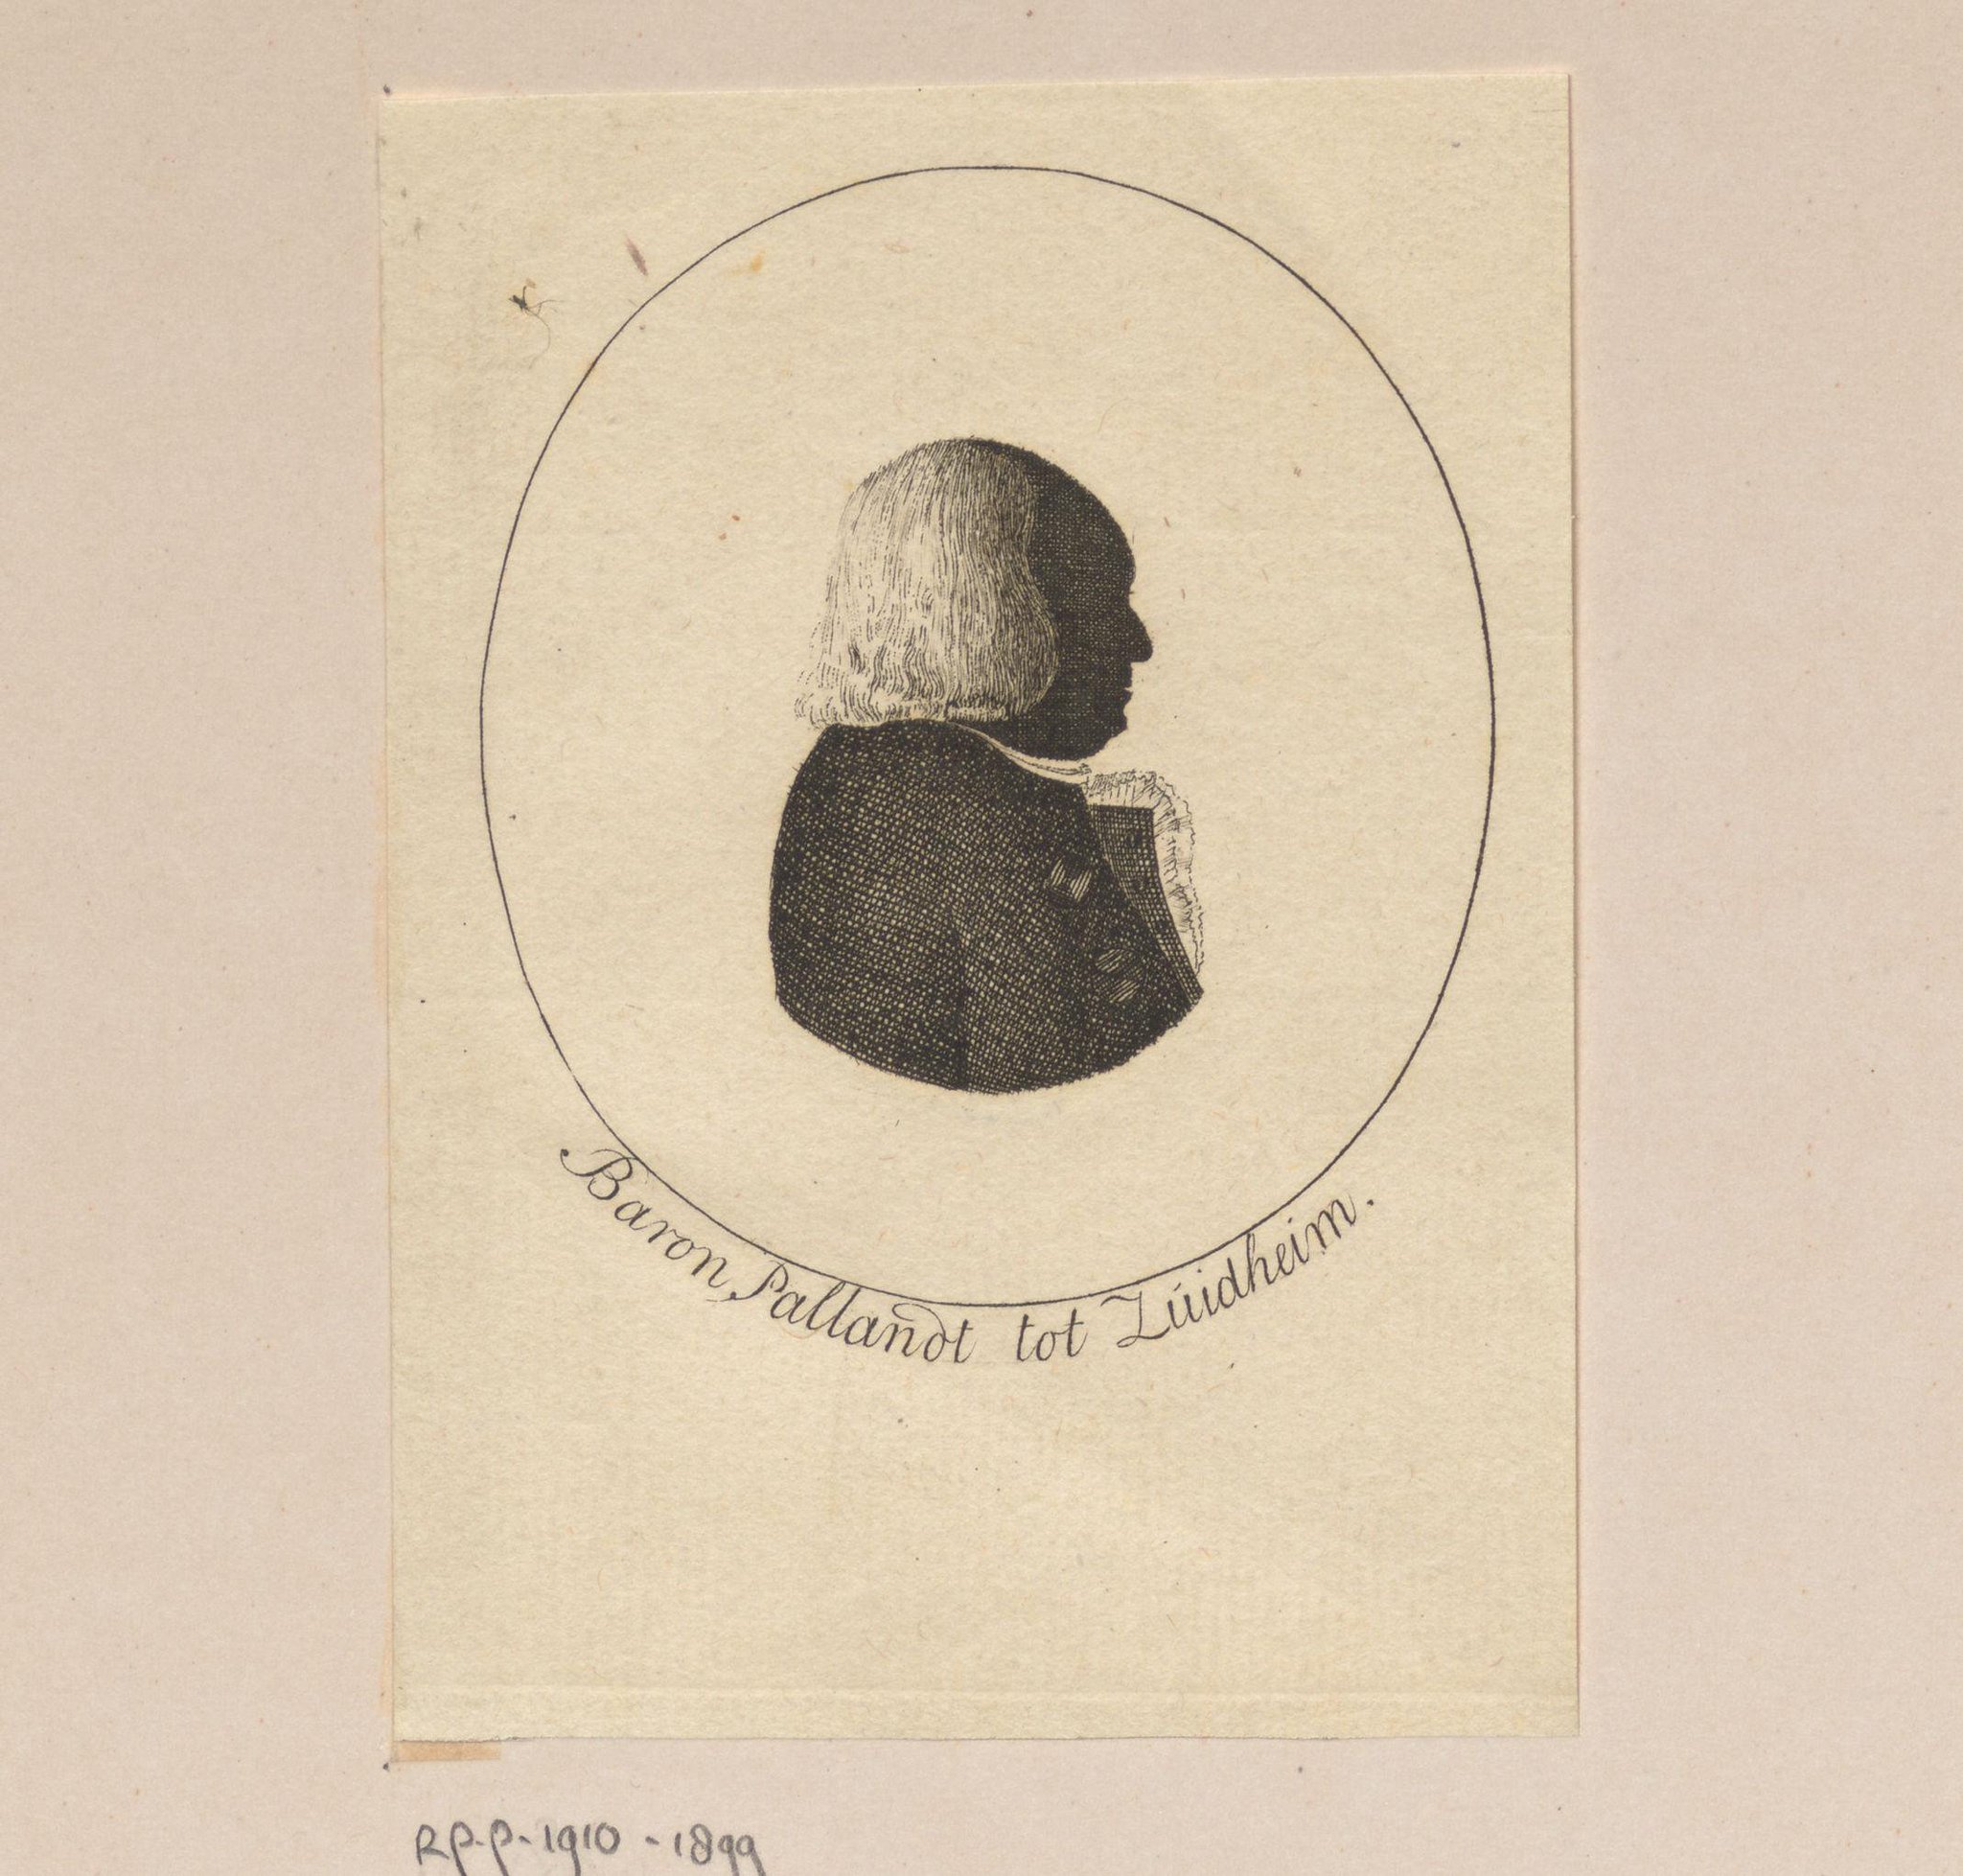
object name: print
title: Portret van Adolph Werner van Pallandt tot Zuthem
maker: Anonymous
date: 1750-1849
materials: paper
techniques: engraving, etching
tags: adult man, historical persons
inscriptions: collector's mark: Lugt 2228